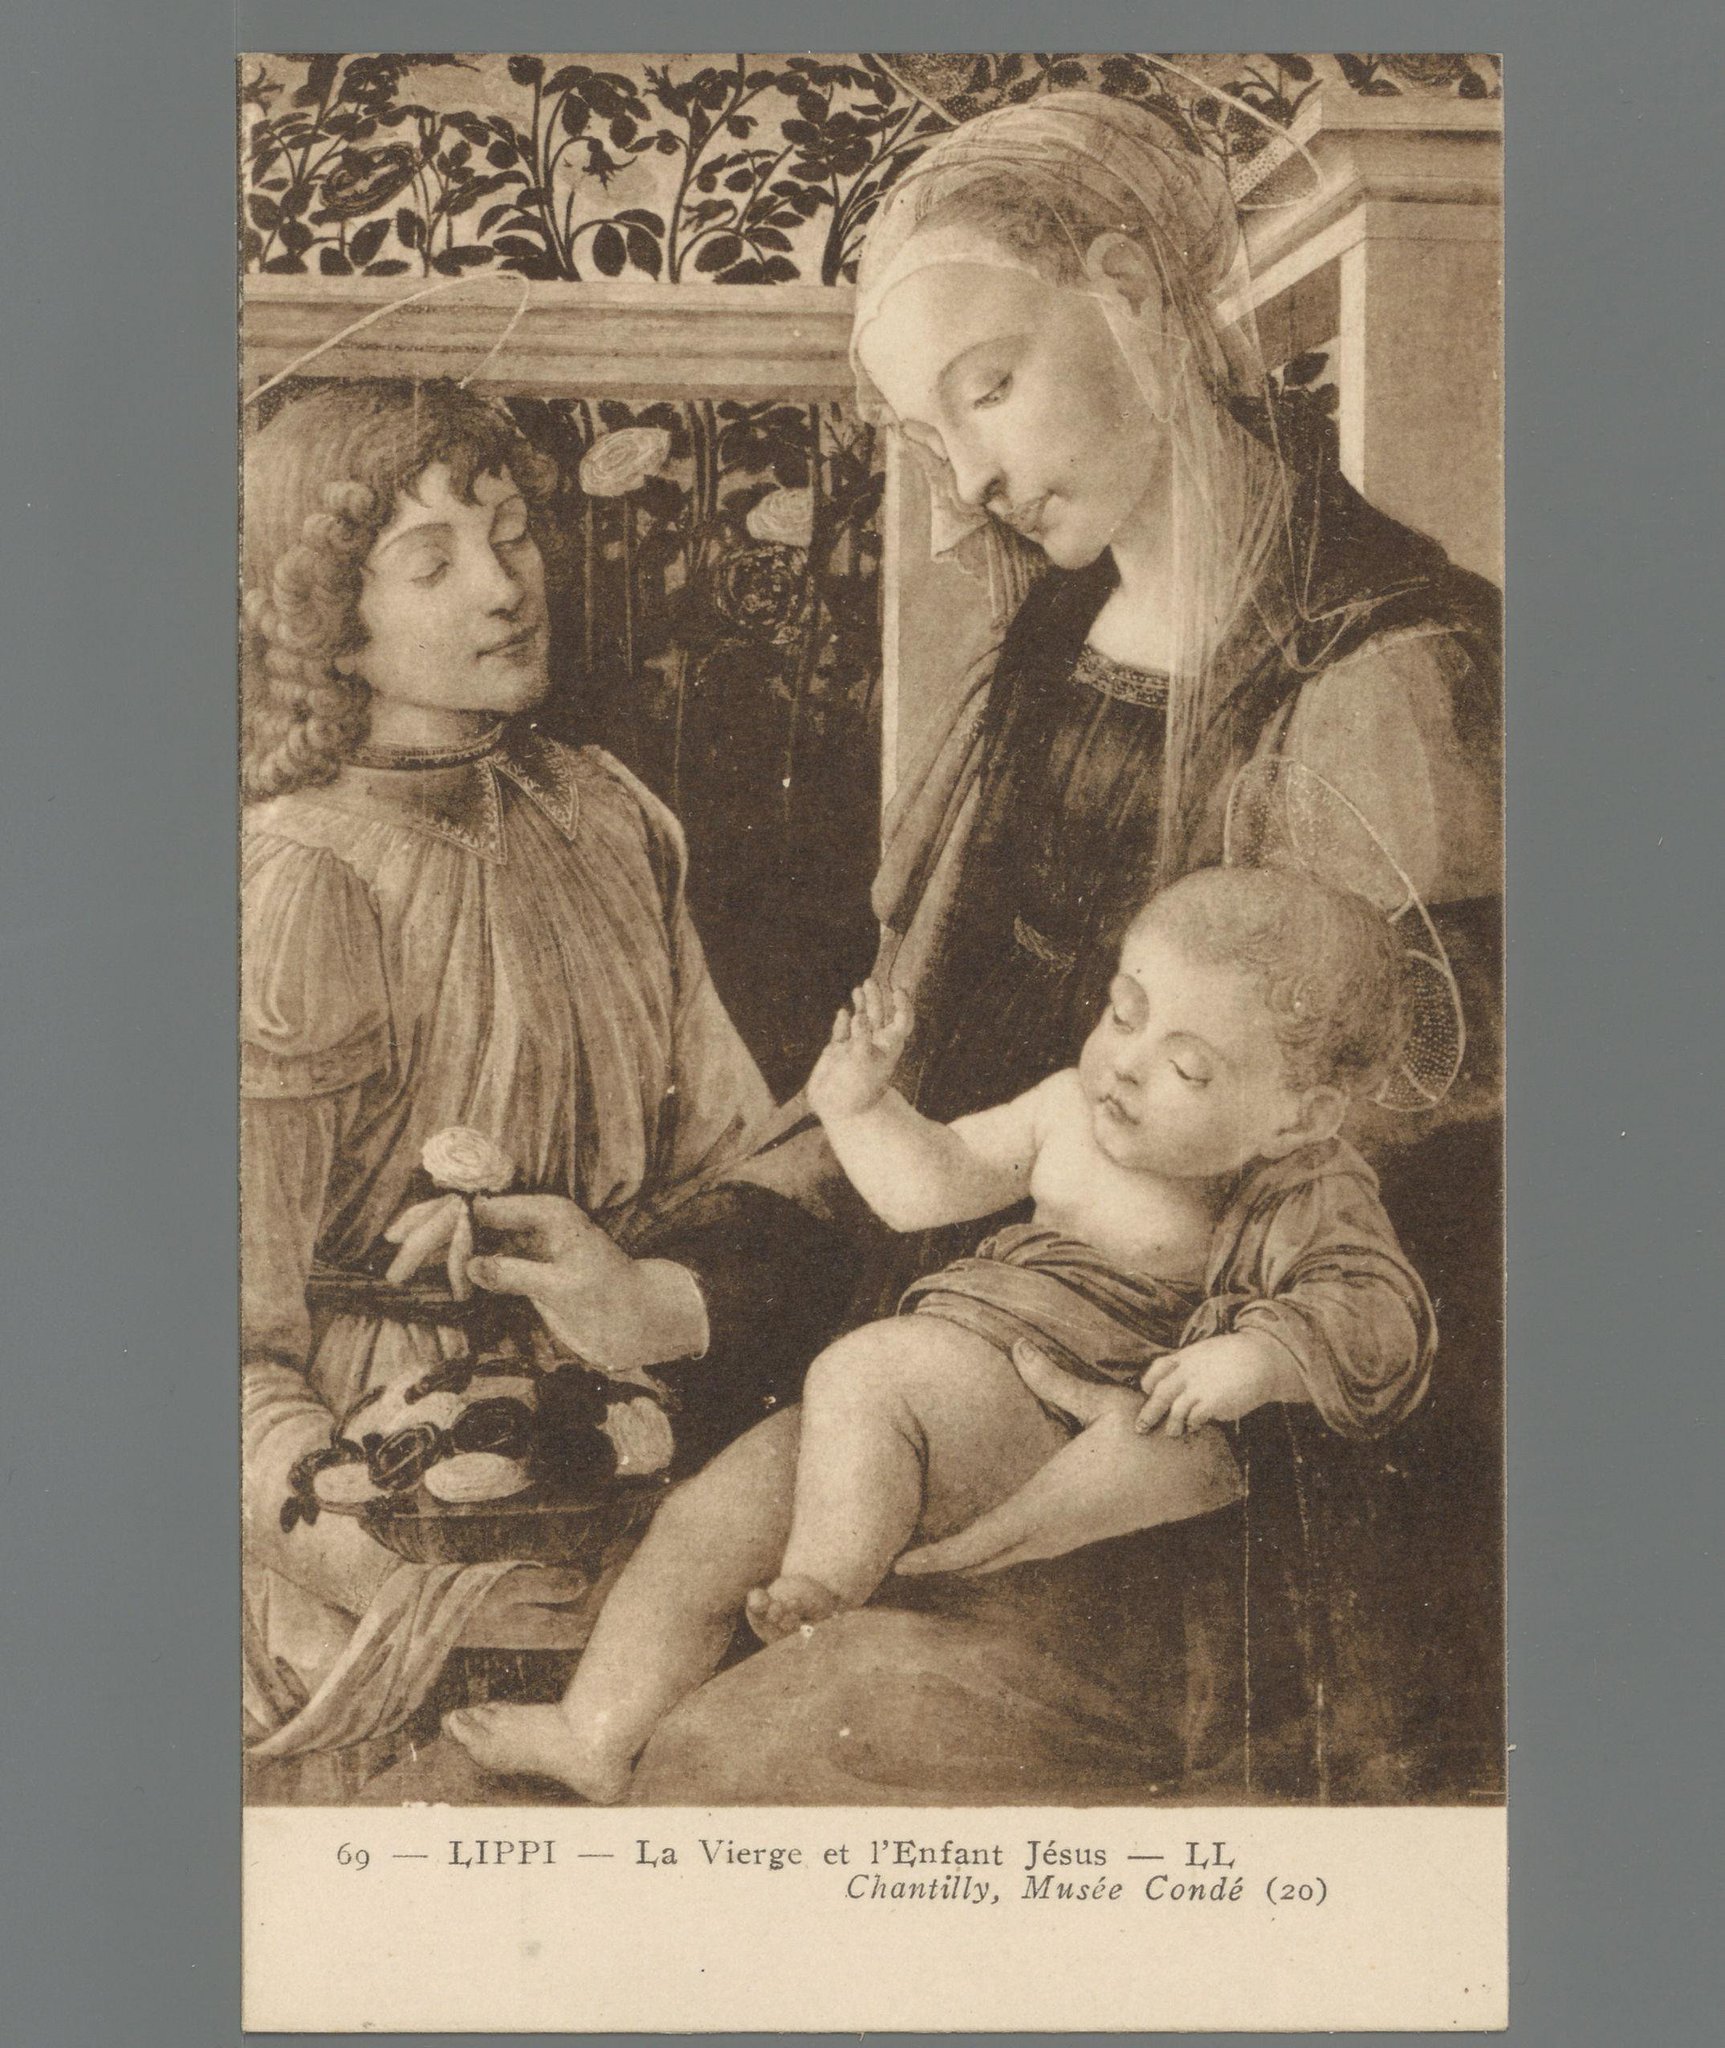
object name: photomechanical print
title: Lippi - La Vierge, l'Enfant-Jésus. Chantilly, Musée Condé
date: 1920-1932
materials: cardboard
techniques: photograph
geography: paris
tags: permanent exhibition, museum, picture, painting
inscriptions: collector's mark: ‘AFE v S’